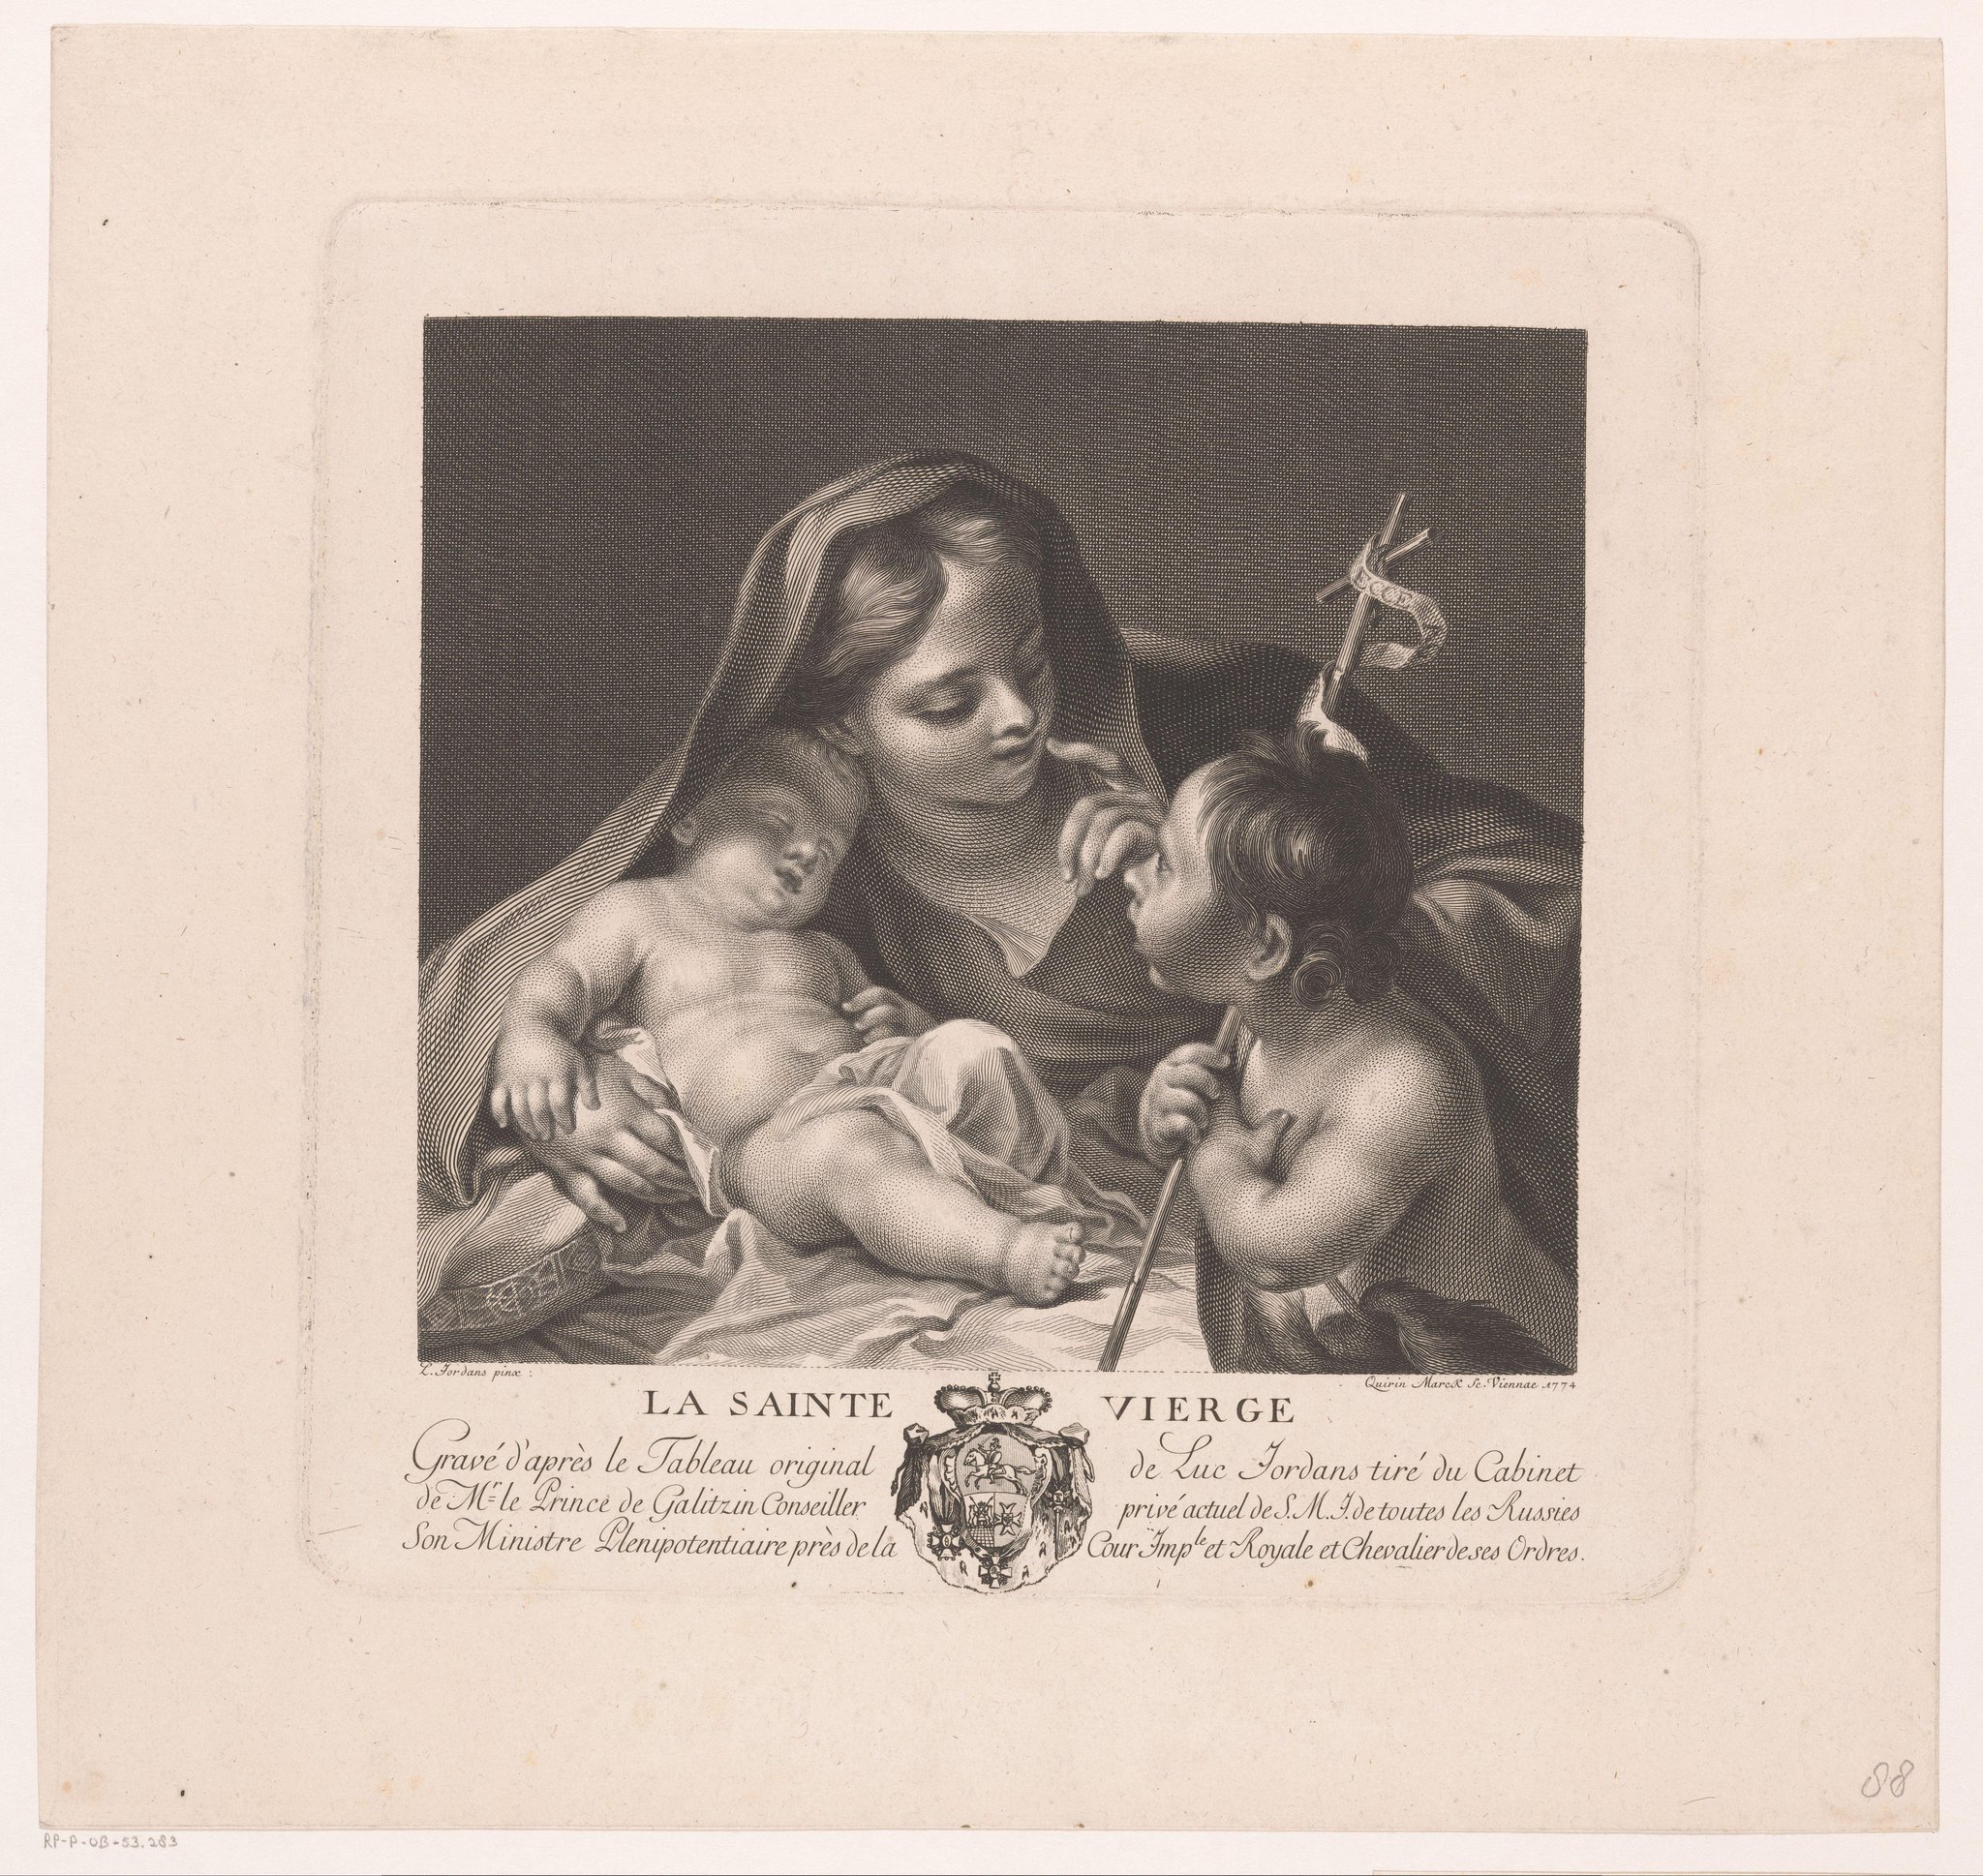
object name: print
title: Maria met slapend Kind en Johannes de Doper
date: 1774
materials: paper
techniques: engraving, etching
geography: vienna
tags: mary and the christ-child with john the baptist (as child), armorial bearing, heraldry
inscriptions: collector's mark: Lugt 240